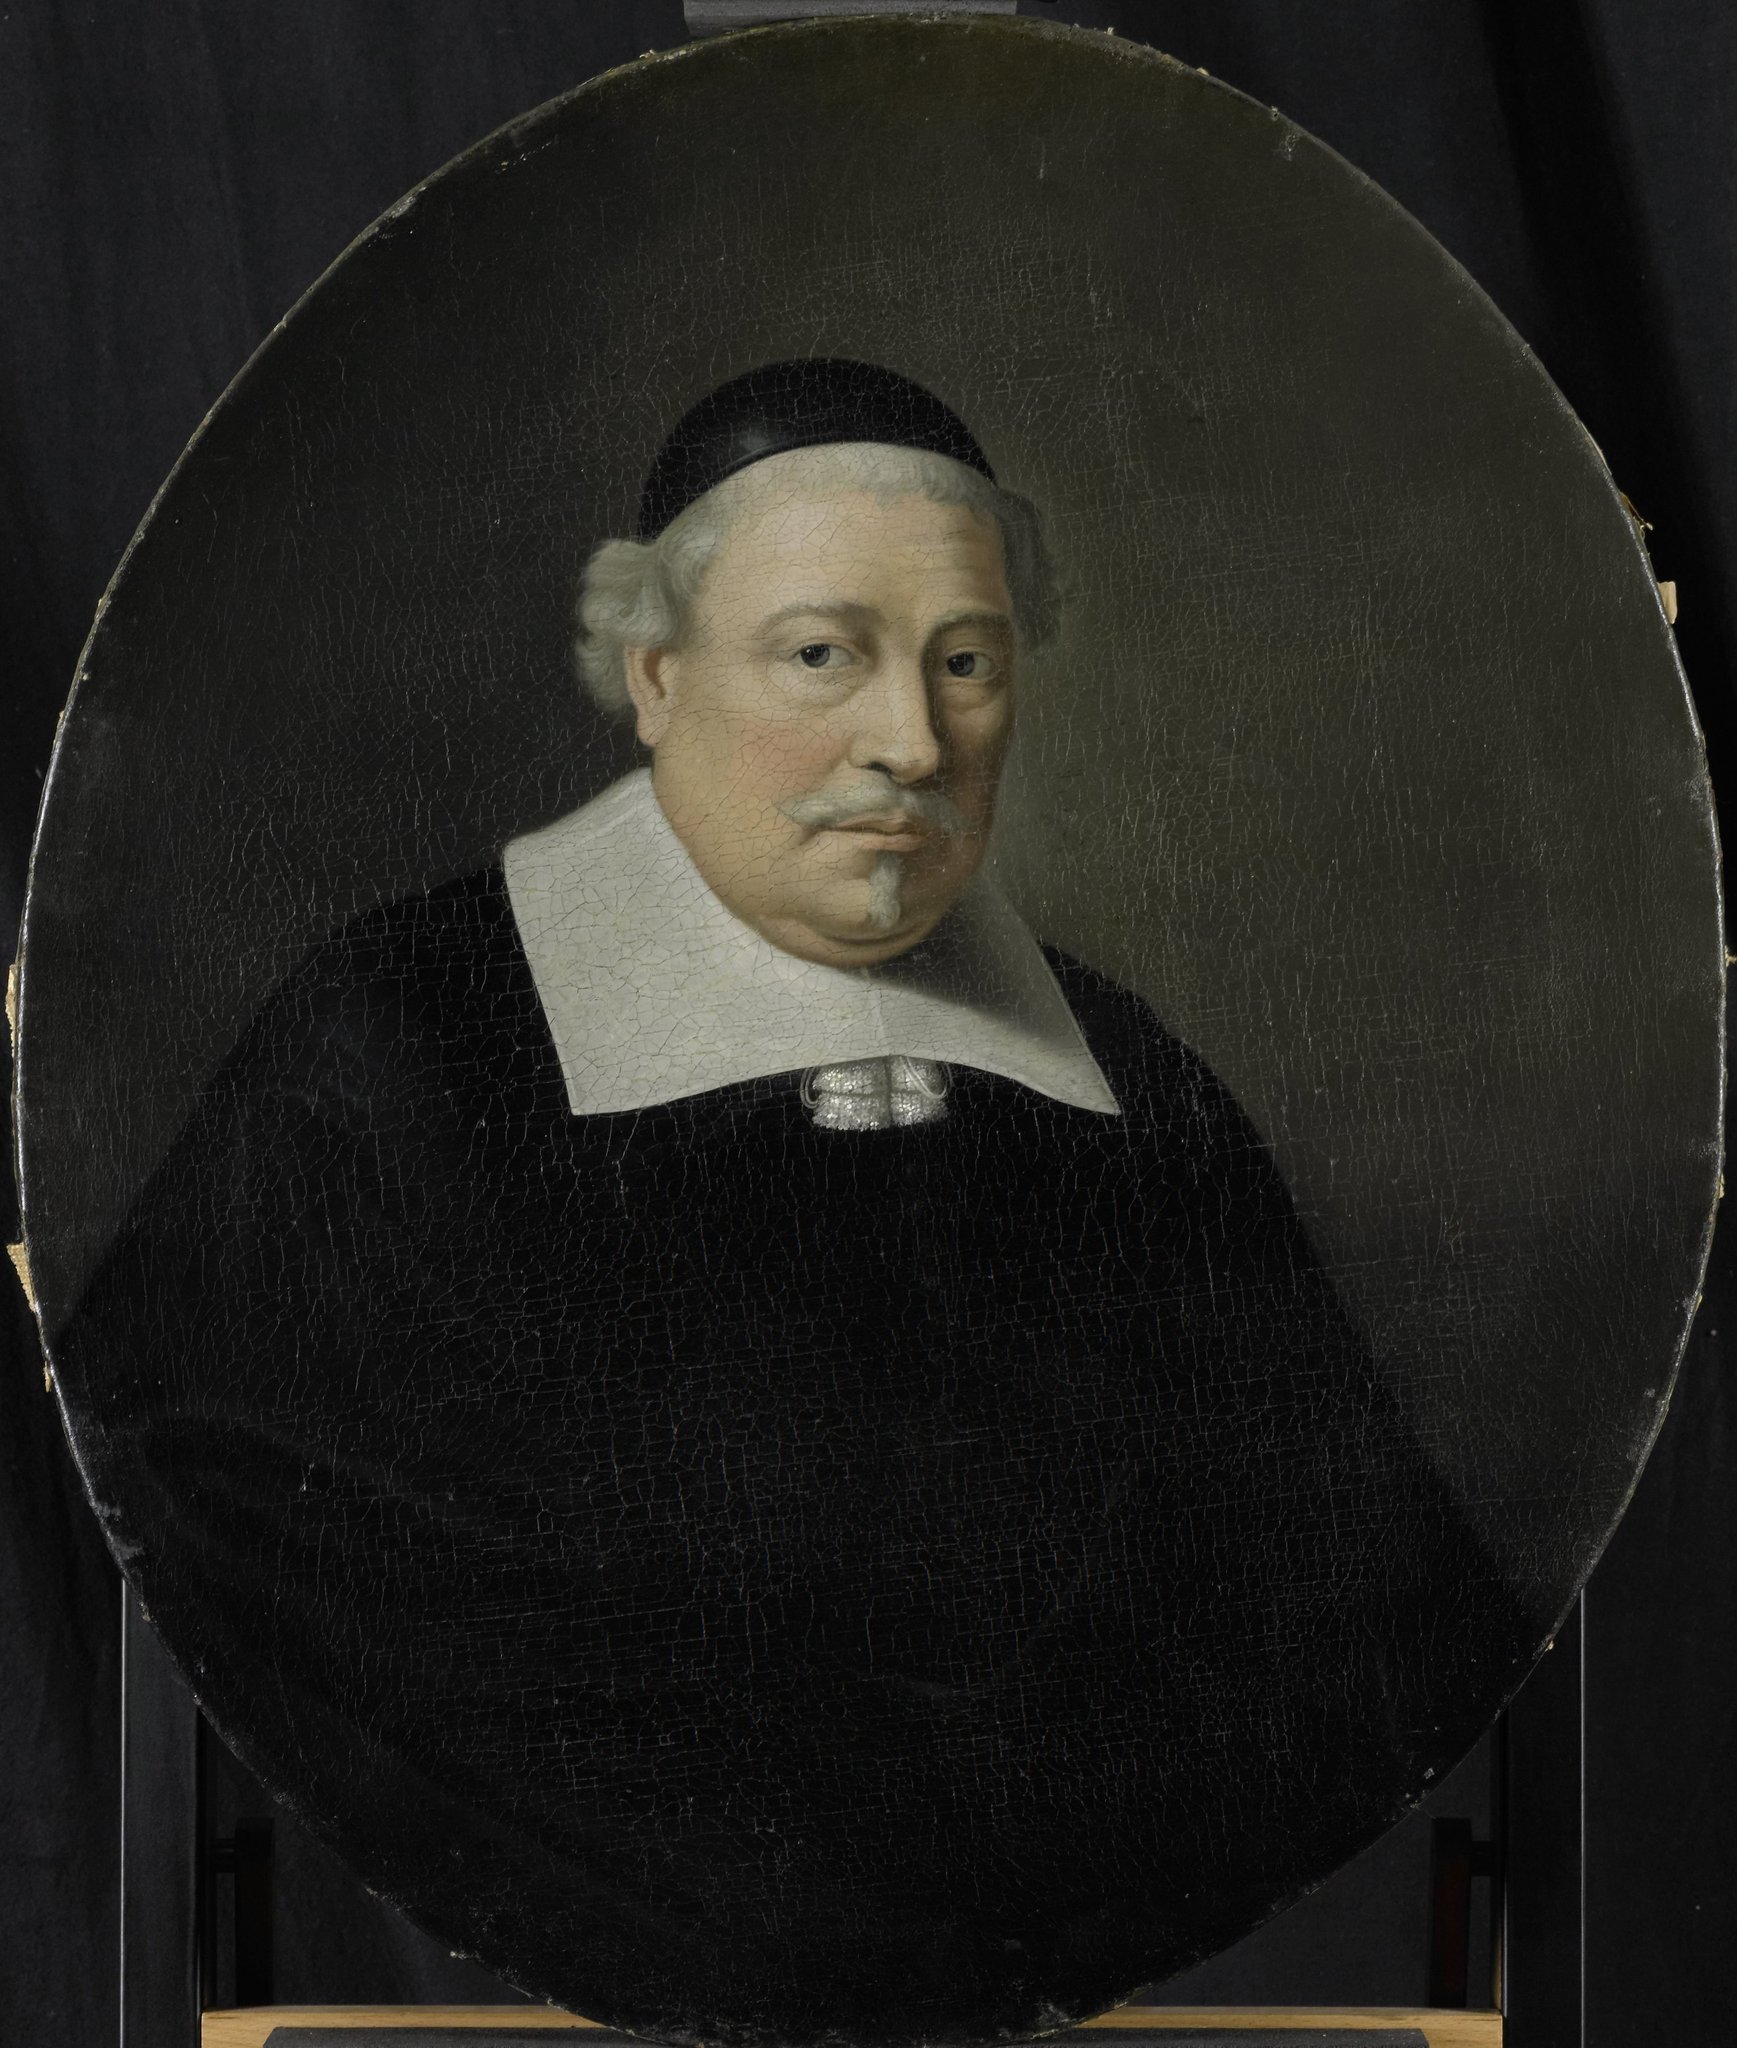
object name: painting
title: Portrait of Cornelis de Koningh, Director of the Rotterdam Chamber of the Dutch East India Company, elected 1649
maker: pieter van der werff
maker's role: draughtsman, painter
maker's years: 1665-1722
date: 1695-1722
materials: canvas, oil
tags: rotterdam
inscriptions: inscription: ‘Cornelis de Koningh.’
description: Portret van Cornelis de Koningh (Cornelis Coninck), gekozen in 1649. Buste in ovaal naar rechts. Onderdeel van een reeks portretten van de bewindhebbers van de Rotterdamse Kamer van de Verenigde Oost-Indische Compagnie, vervaardigd voor het Nieuw Oost-Indisch Huis uit 1698 aan de Boompjes te Rotterdam.